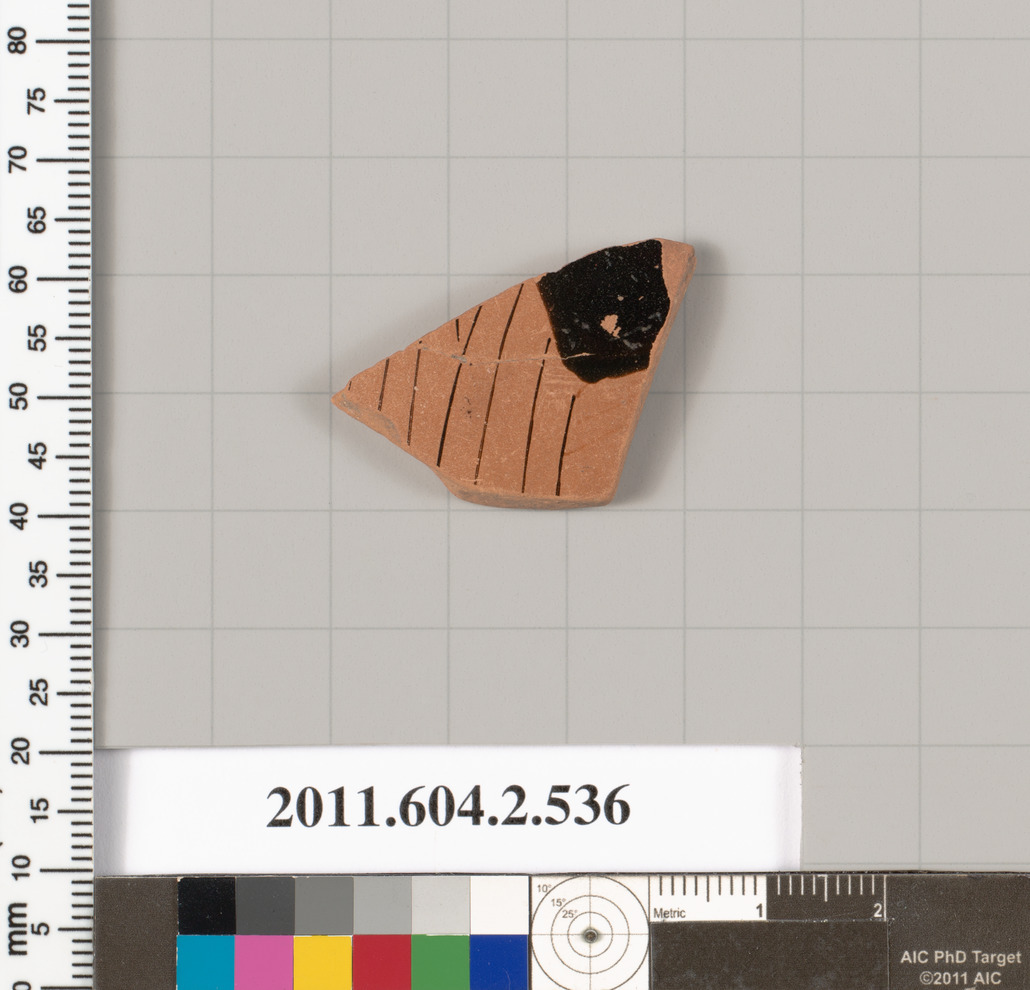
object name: column krater fragment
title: Terracotta fragment of a column-krater (bowl for mixing wine and water)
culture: greek, attic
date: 450-430 BCE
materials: terracotta